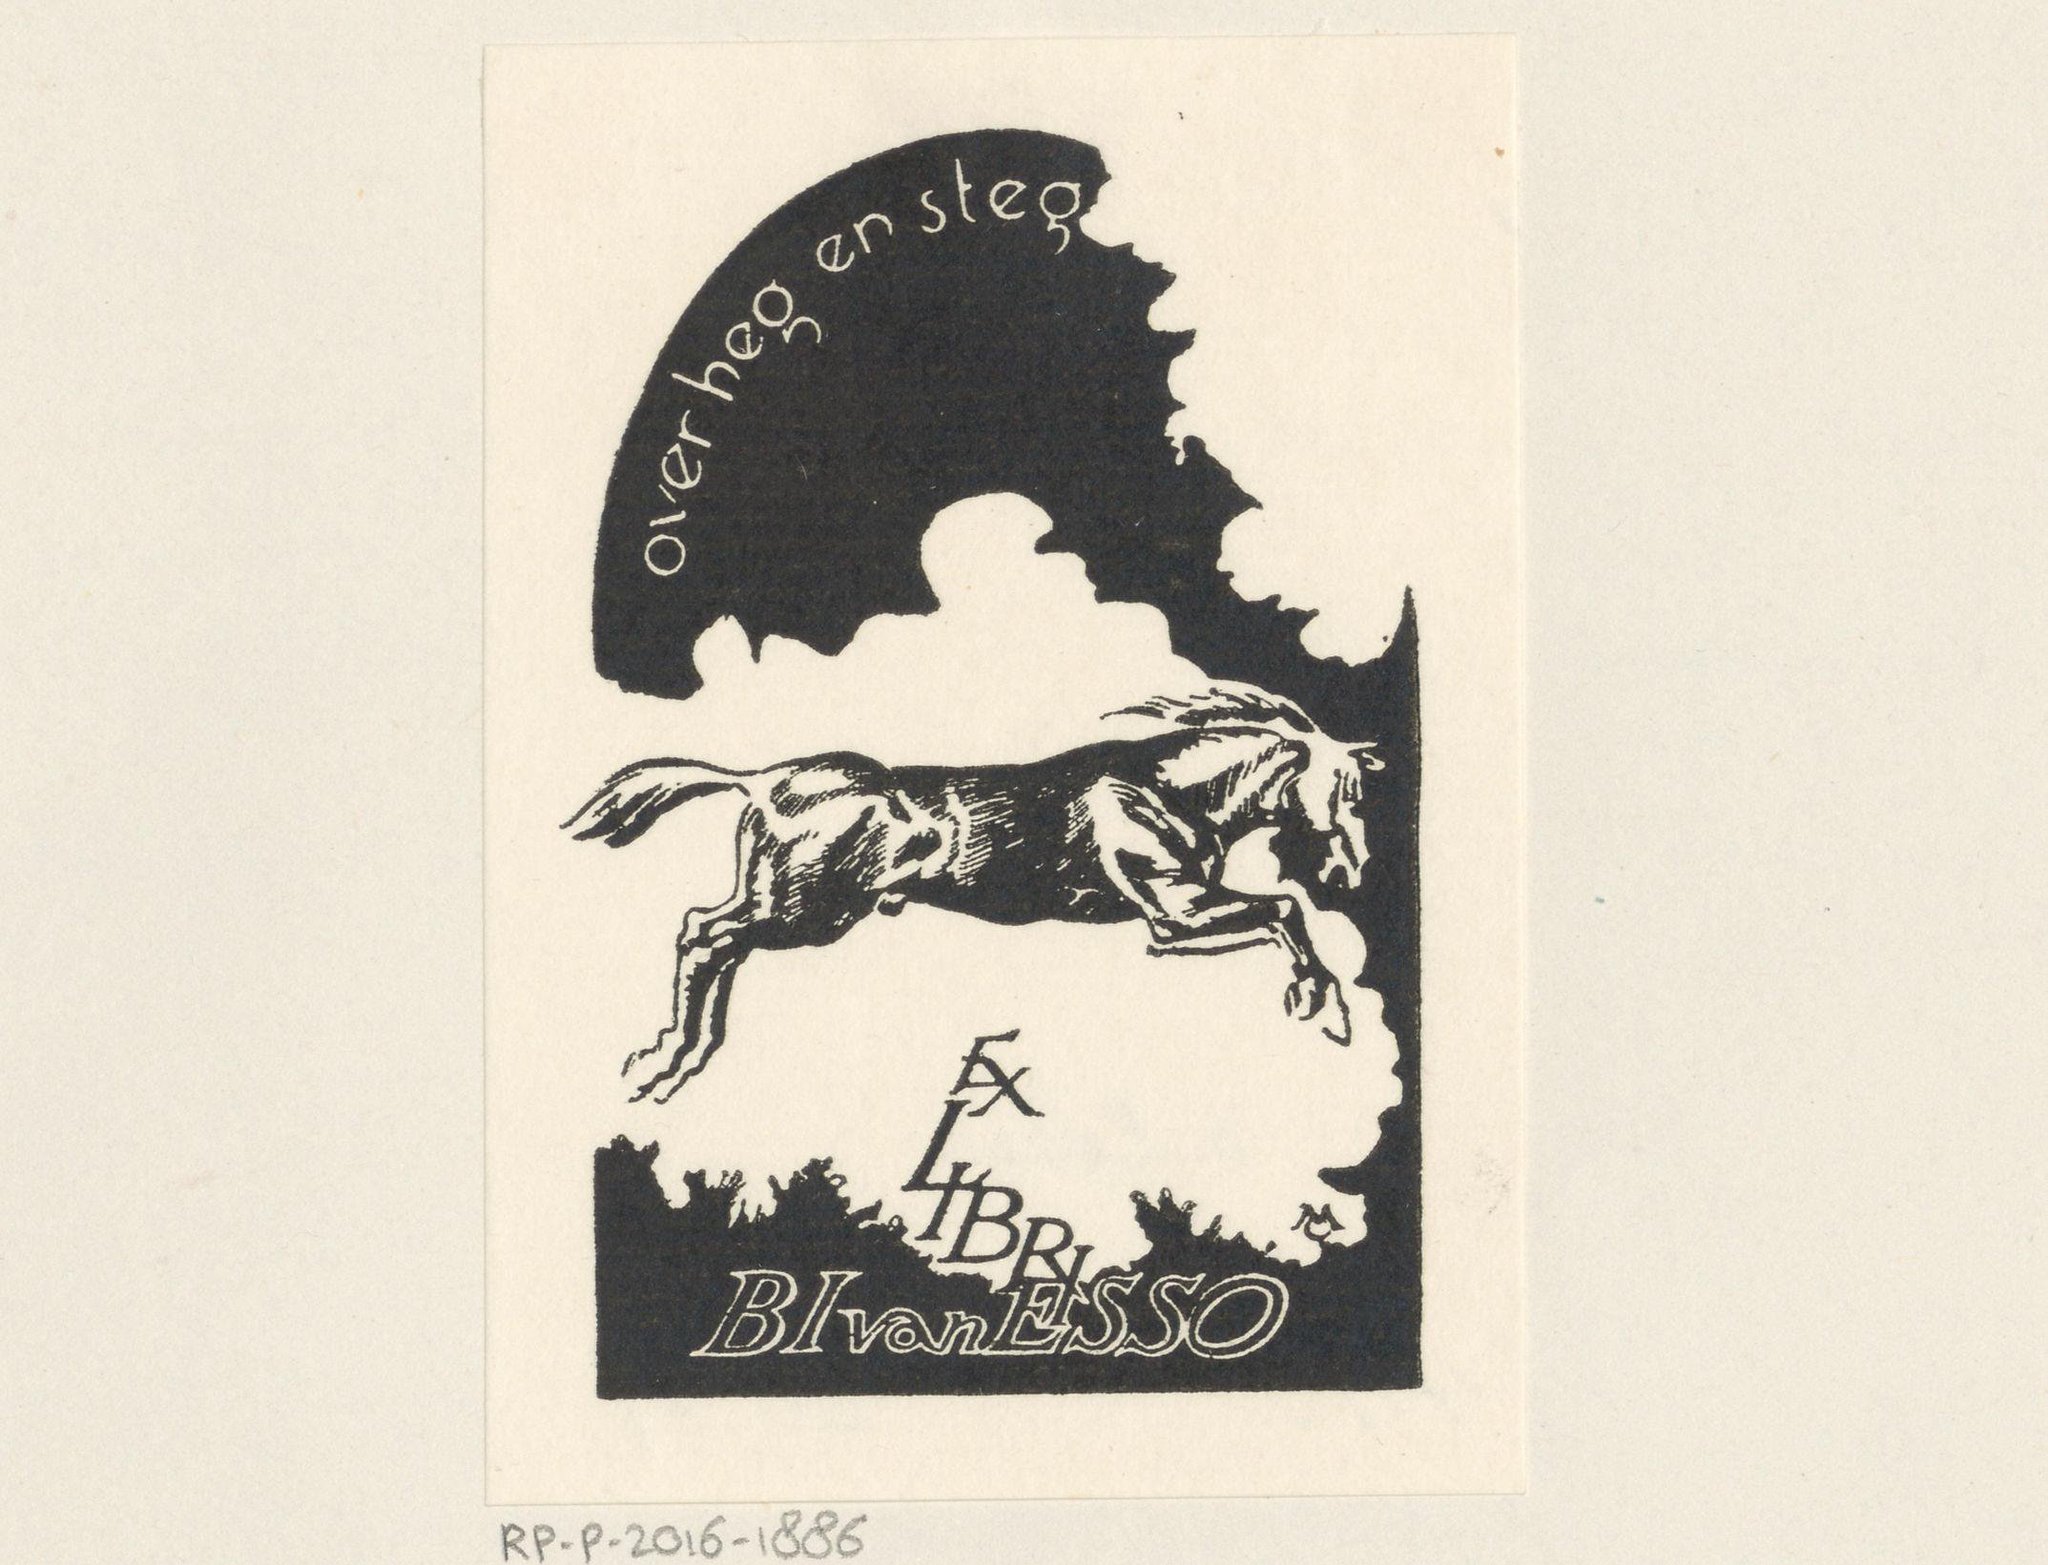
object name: bookplate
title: Ex libris van B.I. van Esso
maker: moses cohen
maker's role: print maker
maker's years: 1901-1942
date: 1937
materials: paper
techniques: printing block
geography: netherlands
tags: hoofed animals: stag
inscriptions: monogram and date: ‘MC / Cl '37’